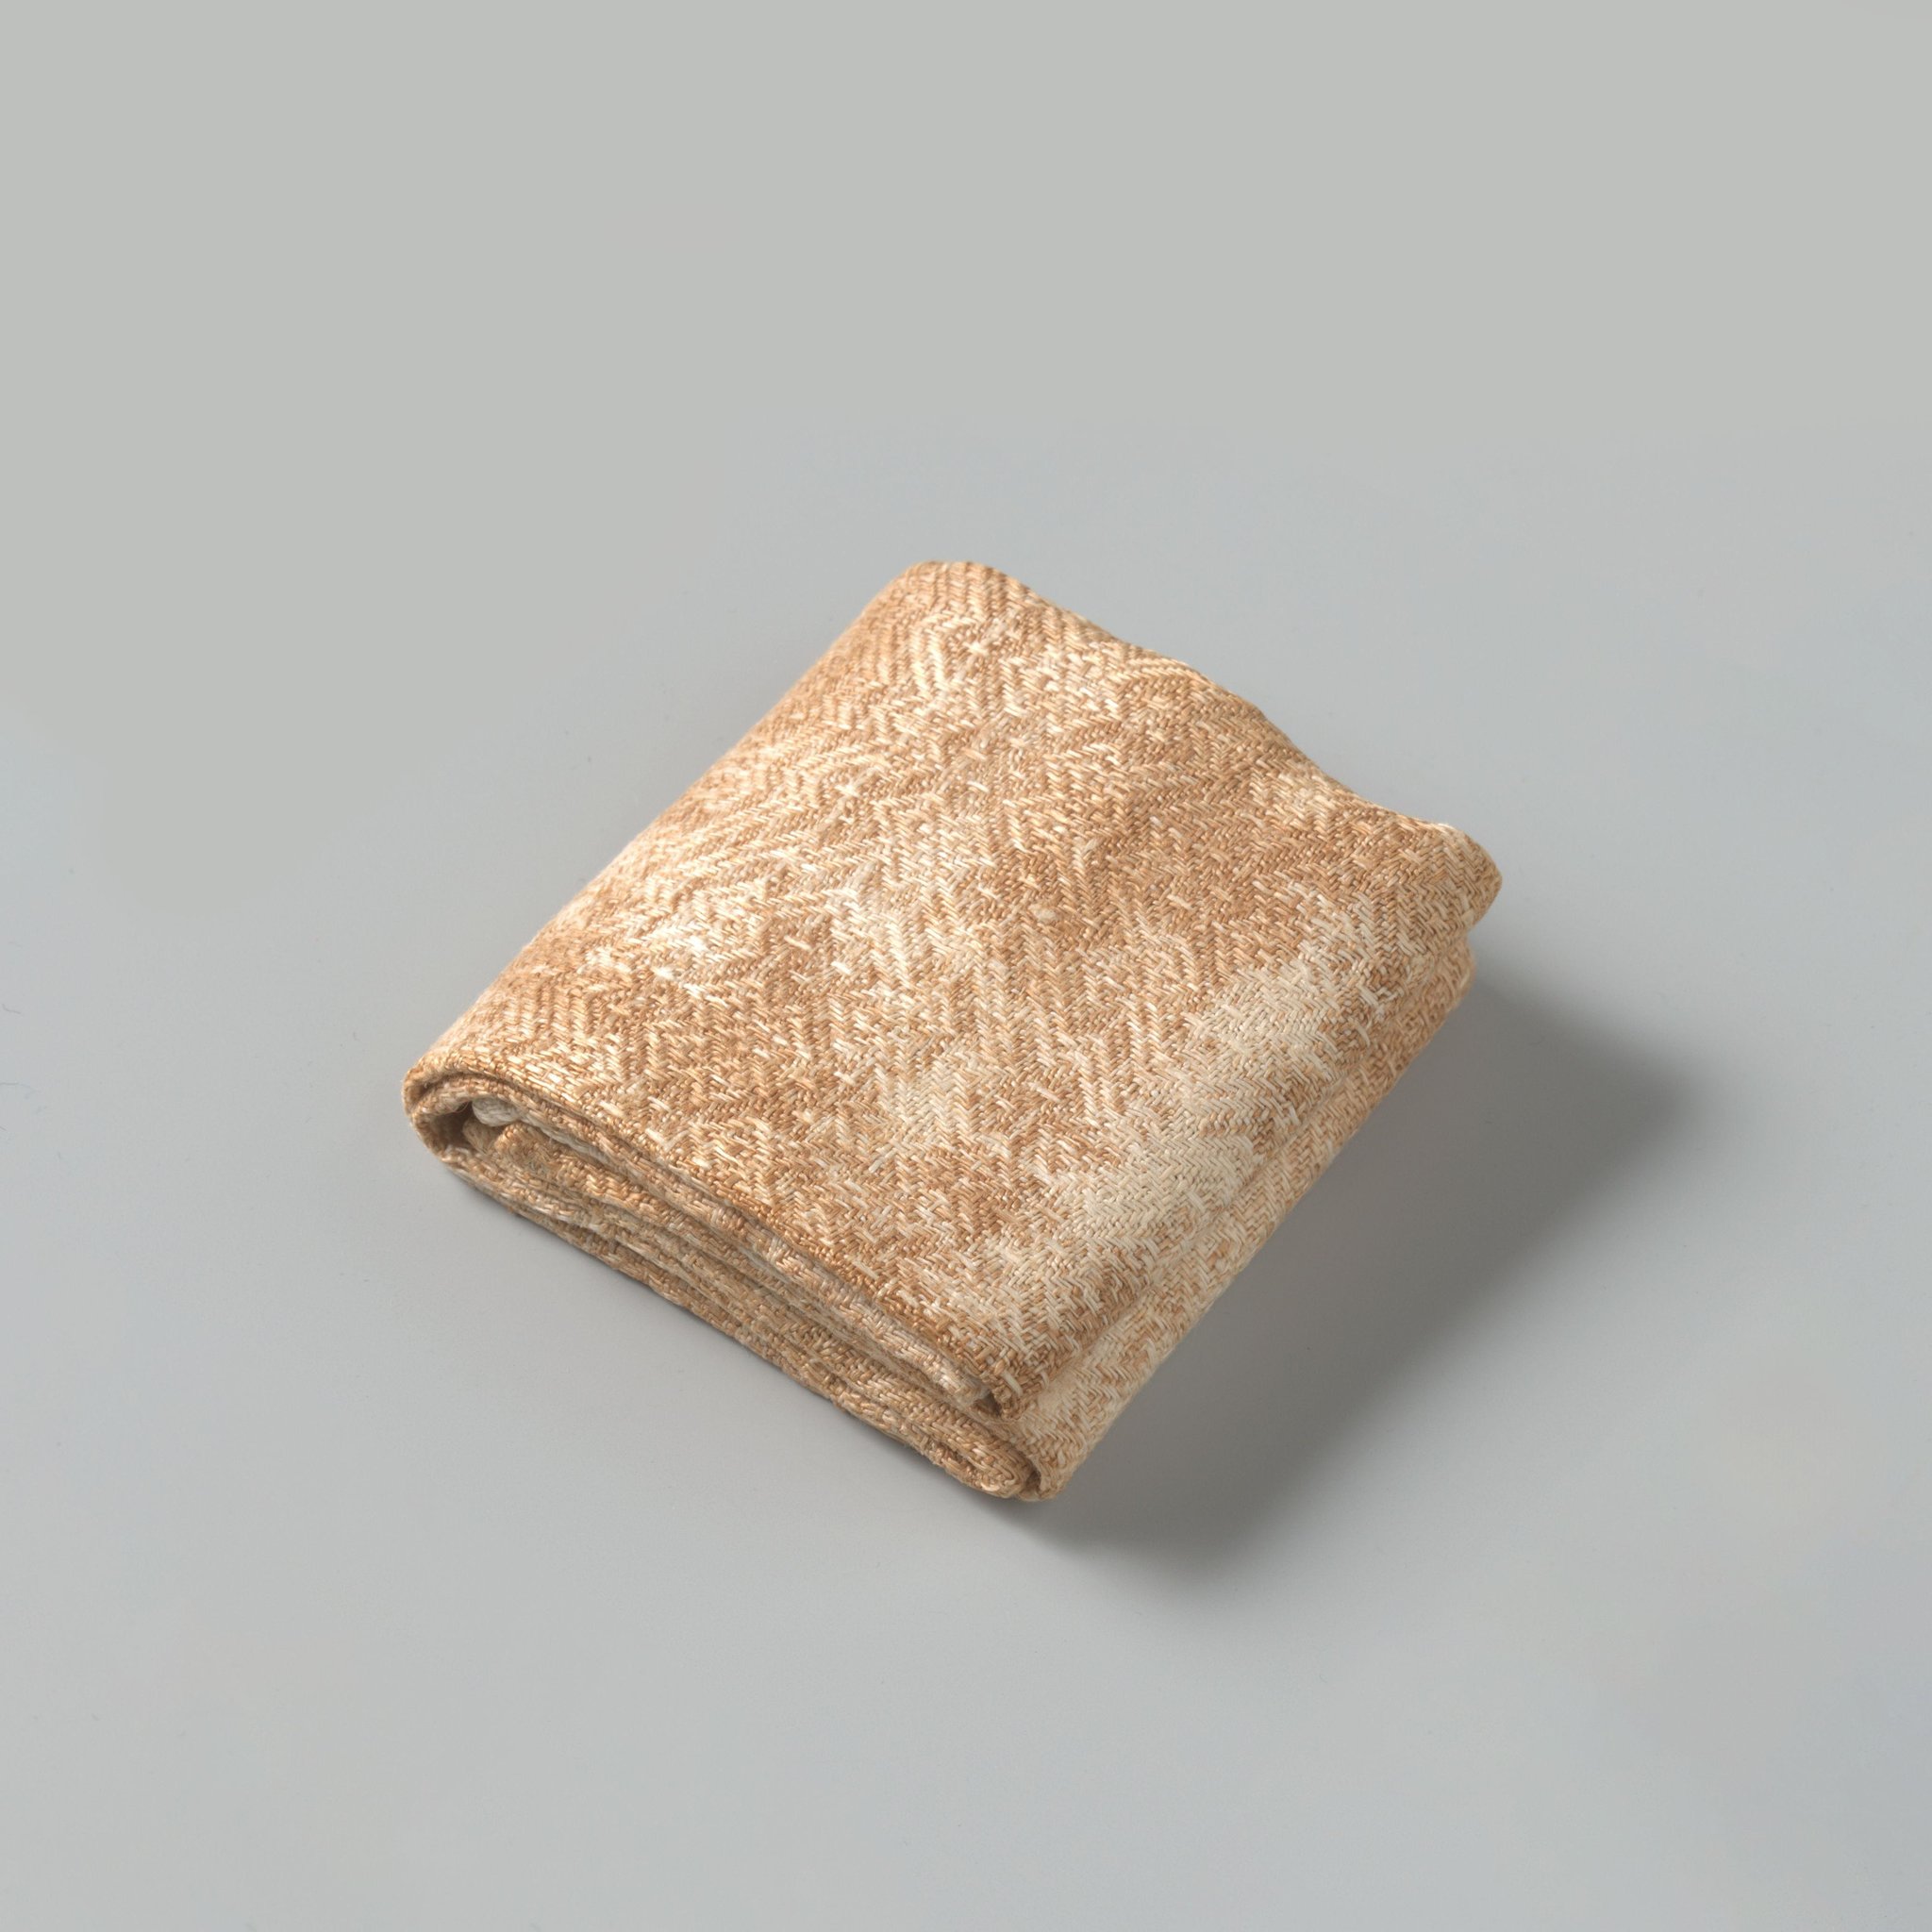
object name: tablecloth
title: Tafellaken, damastweefsel met een pellenpatroon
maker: Anonymous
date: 1600-1699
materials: linen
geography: netherlands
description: Tafellaken, damastweefsel met een pellenpatroon, geknipt uit grotere stukken linnen en aan alle kanten omgezoomd met een fijne zoom.